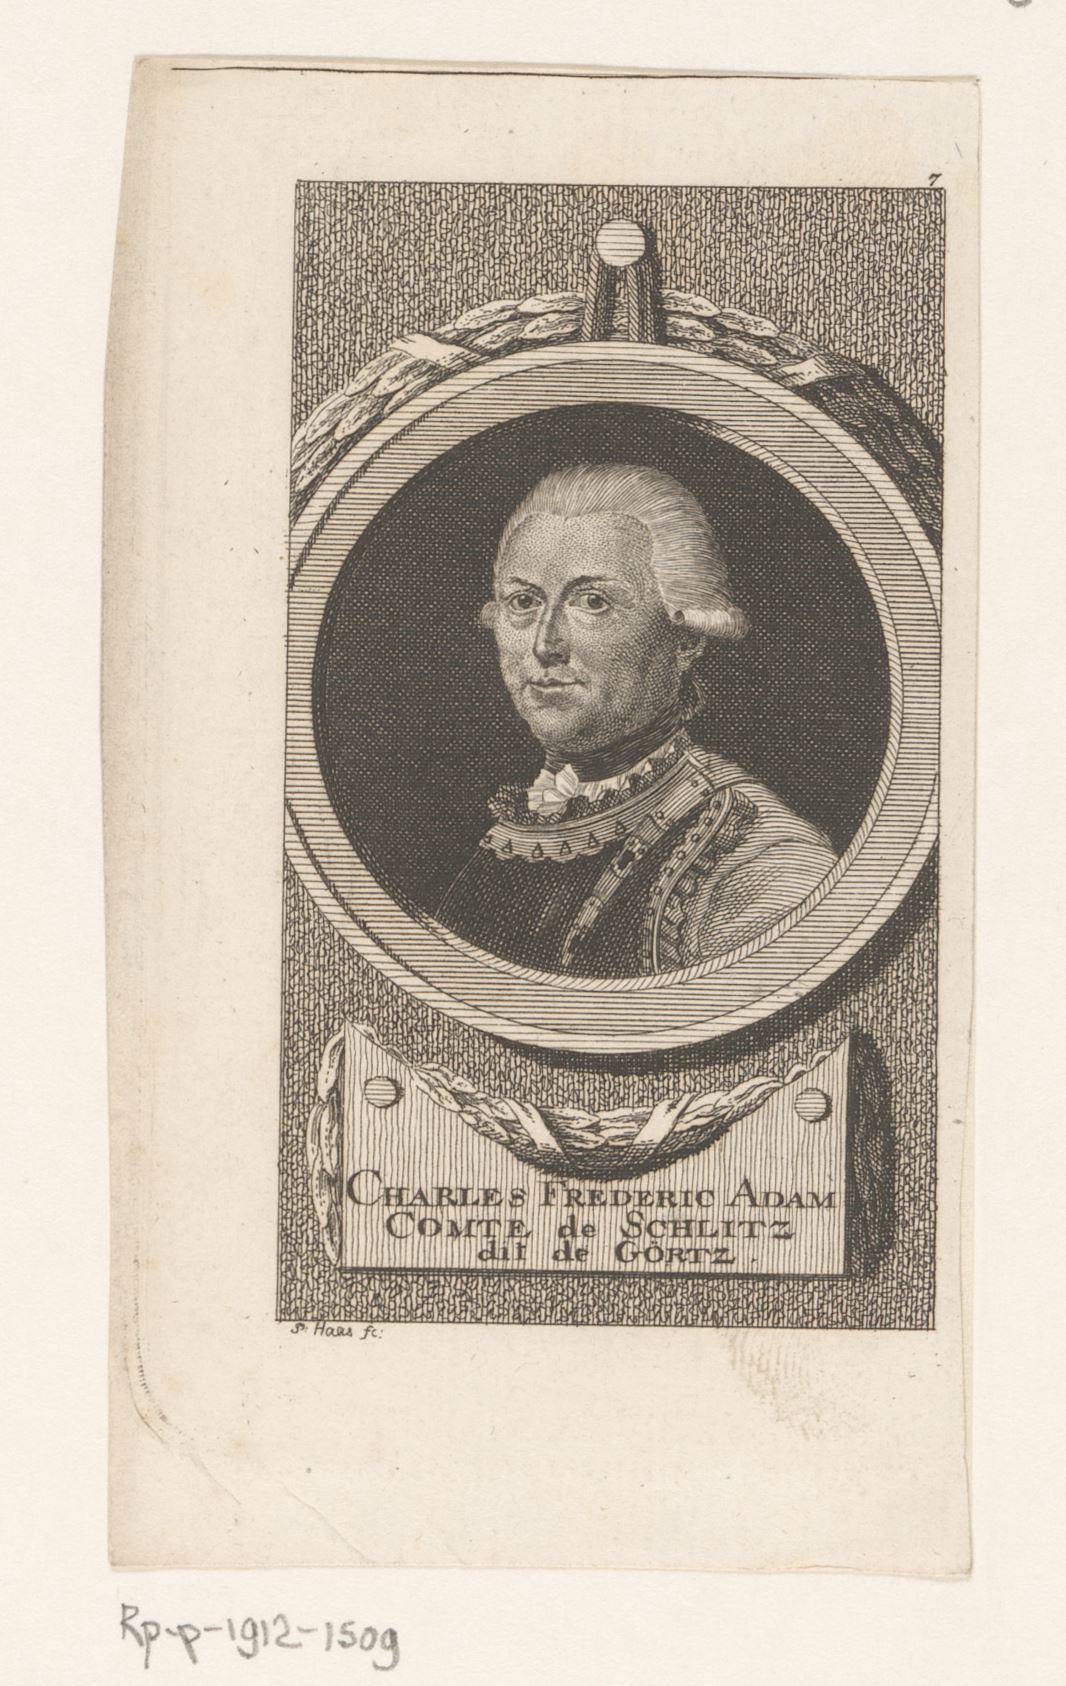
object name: print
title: Portret van Karl Friedrich Adam Graf von Görtz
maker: peter haas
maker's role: print maker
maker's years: 1754-1804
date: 1764-1804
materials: paper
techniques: engraving, etching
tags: ornament ~ medallion, commander-in-chief, general, marshal, historical persons, ornament ~ festoon, garland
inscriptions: collector's mark: Lugt 2228